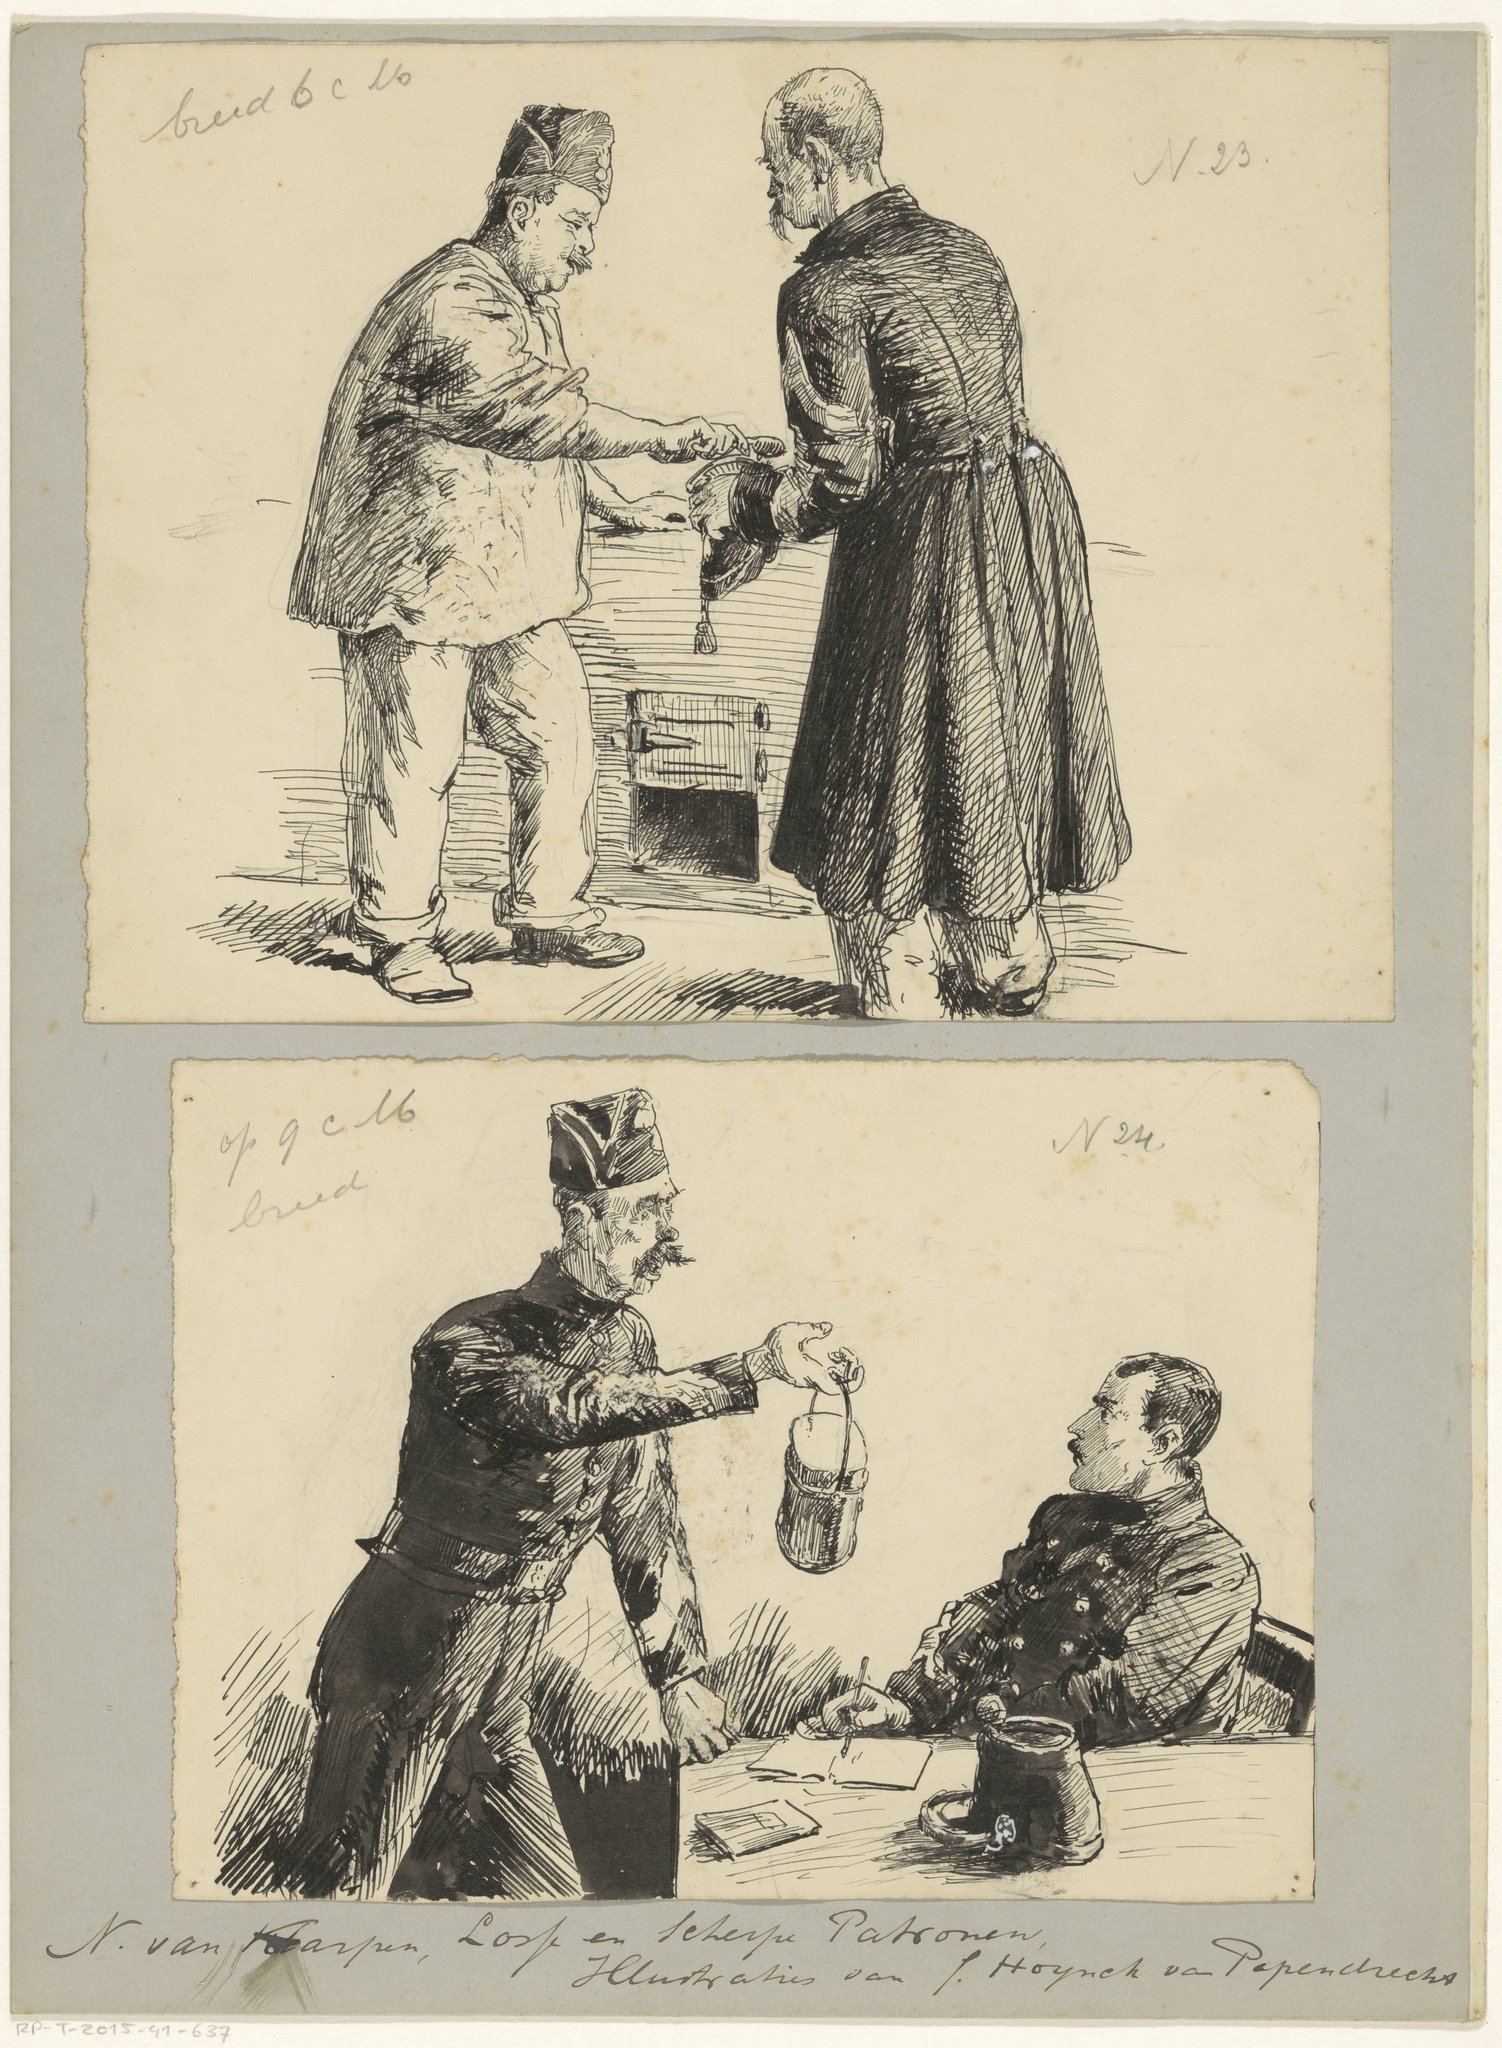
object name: boekillustratie ontwerp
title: Militair met hoed en militairen in overleg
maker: jan hoynck van papendrecht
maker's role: draughtsman, painter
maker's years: 1858-1933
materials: paint, ink, paper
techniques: brush, pen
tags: head-gear: cap (+ men's clothes), lantern, the soldier; the soldier's life, conversation, dialogue; conversation piece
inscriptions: :, collector's mark: Lugt 2228, annotation: ‘N. 23’, annotation: ‘N 24’, annotation: ‘N. van Harpen, Losse en Scherpe Patronen,/ Illustraties van J. Hoynck van Papendrecht’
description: Twee illustraties op één opzetvel. Boven een militair die zijn hoed aanbiedt aan een man, die vermoedelijk de hoed borstelt of schoonmaakt. Onder twee militairen aan een tafel in overleg. Eén van de mannen houdt een lantaarn in de lucht.